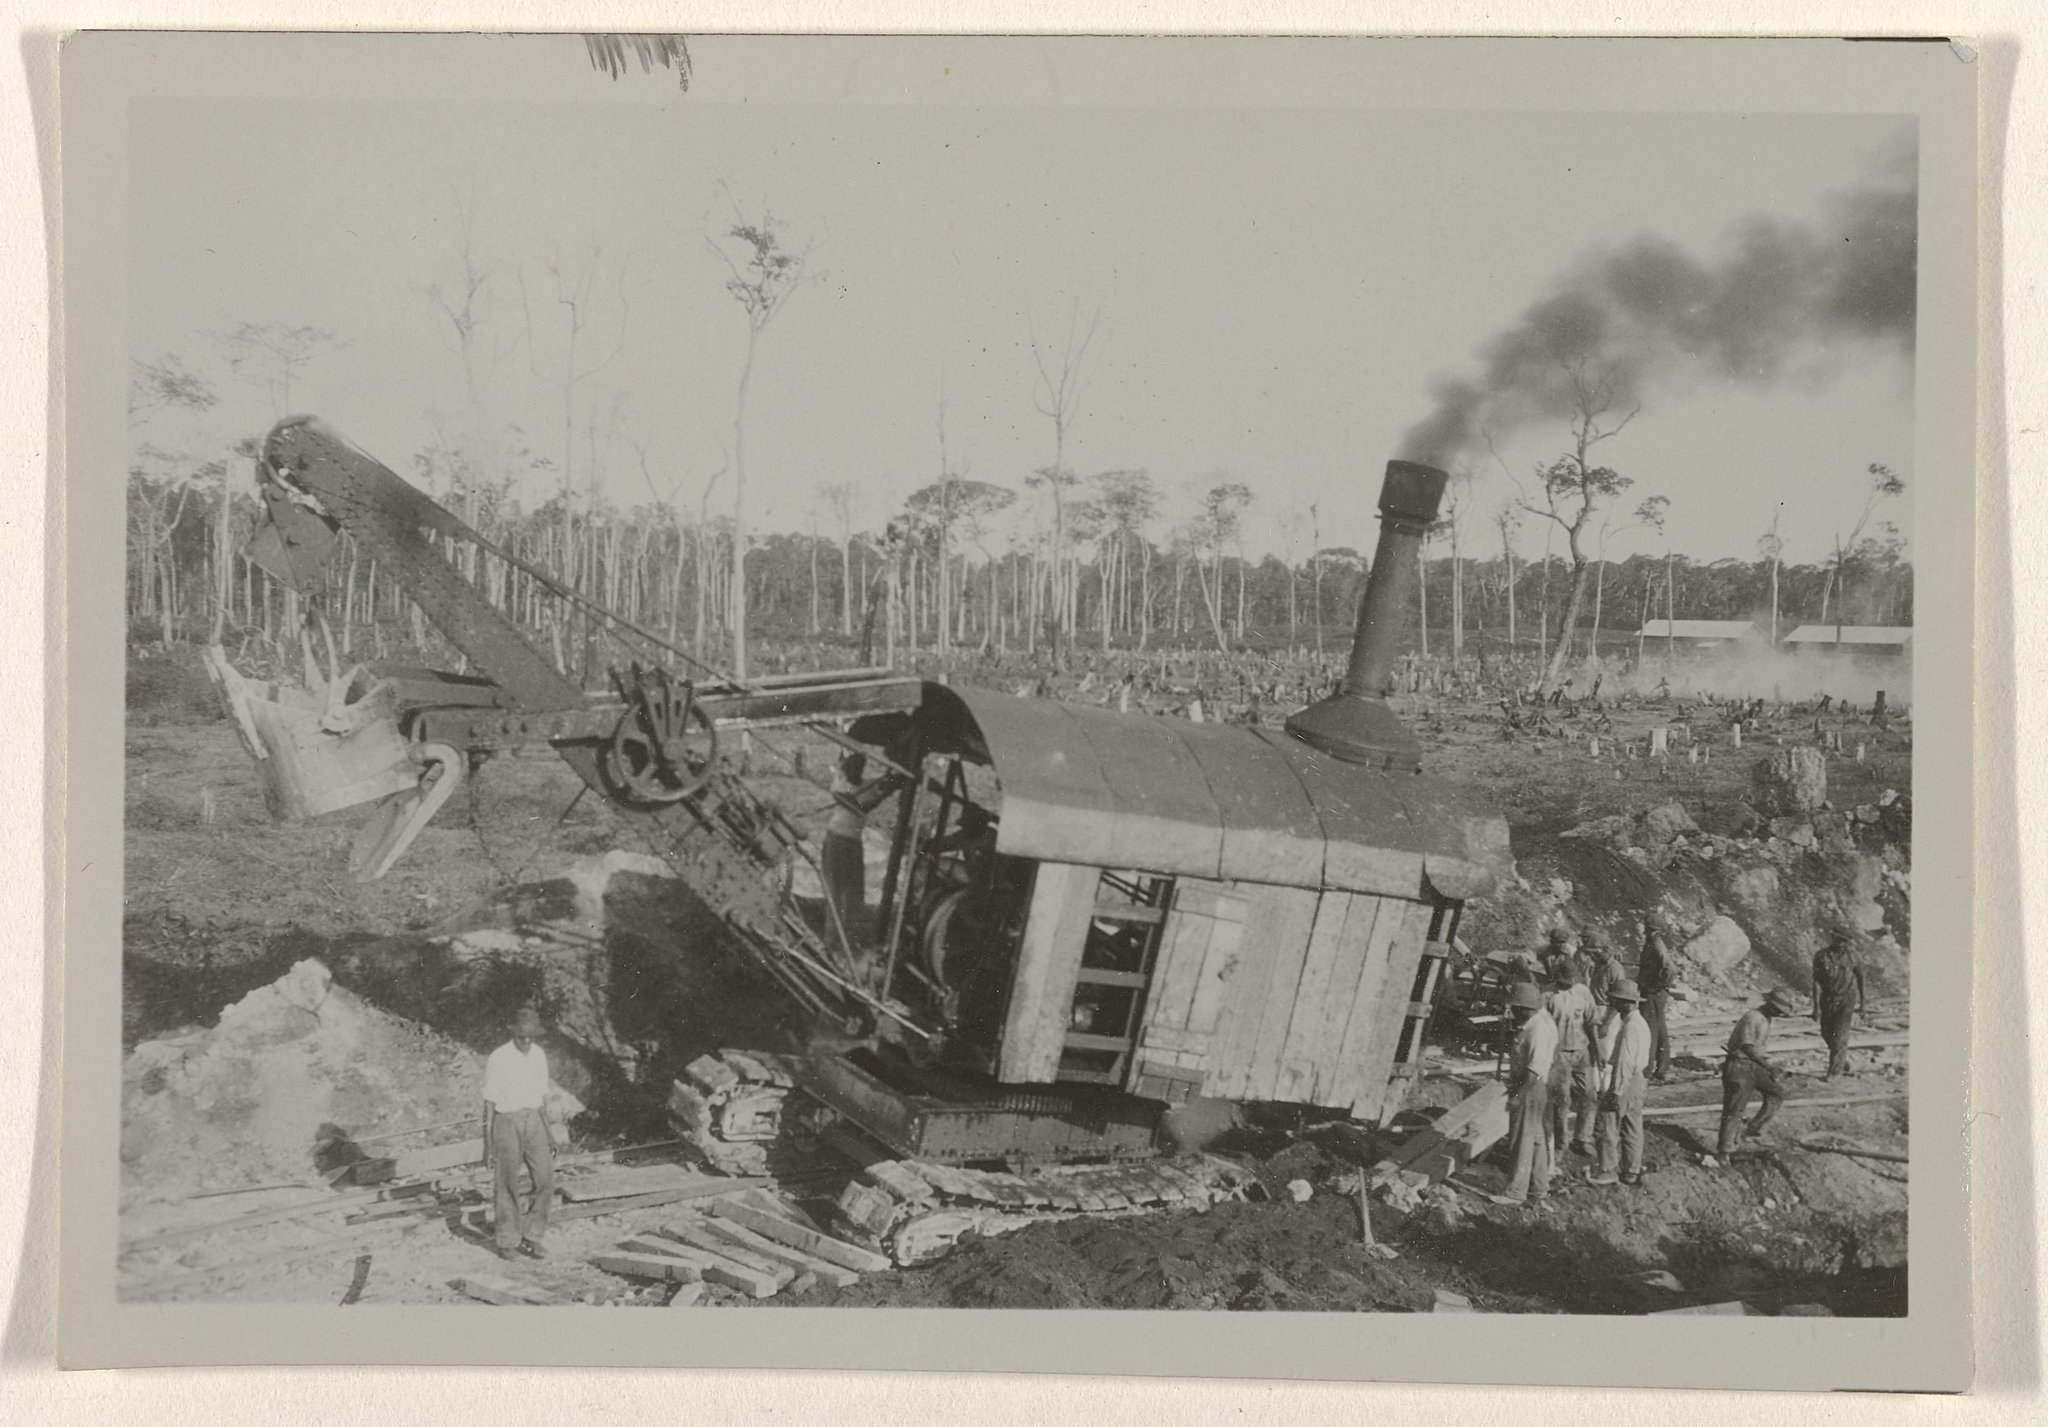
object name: photograph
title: Bauxietwinning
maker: Anonymous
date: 1929-1930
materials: photographic support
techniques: photography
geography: suriname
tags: opencast mine; strip mining